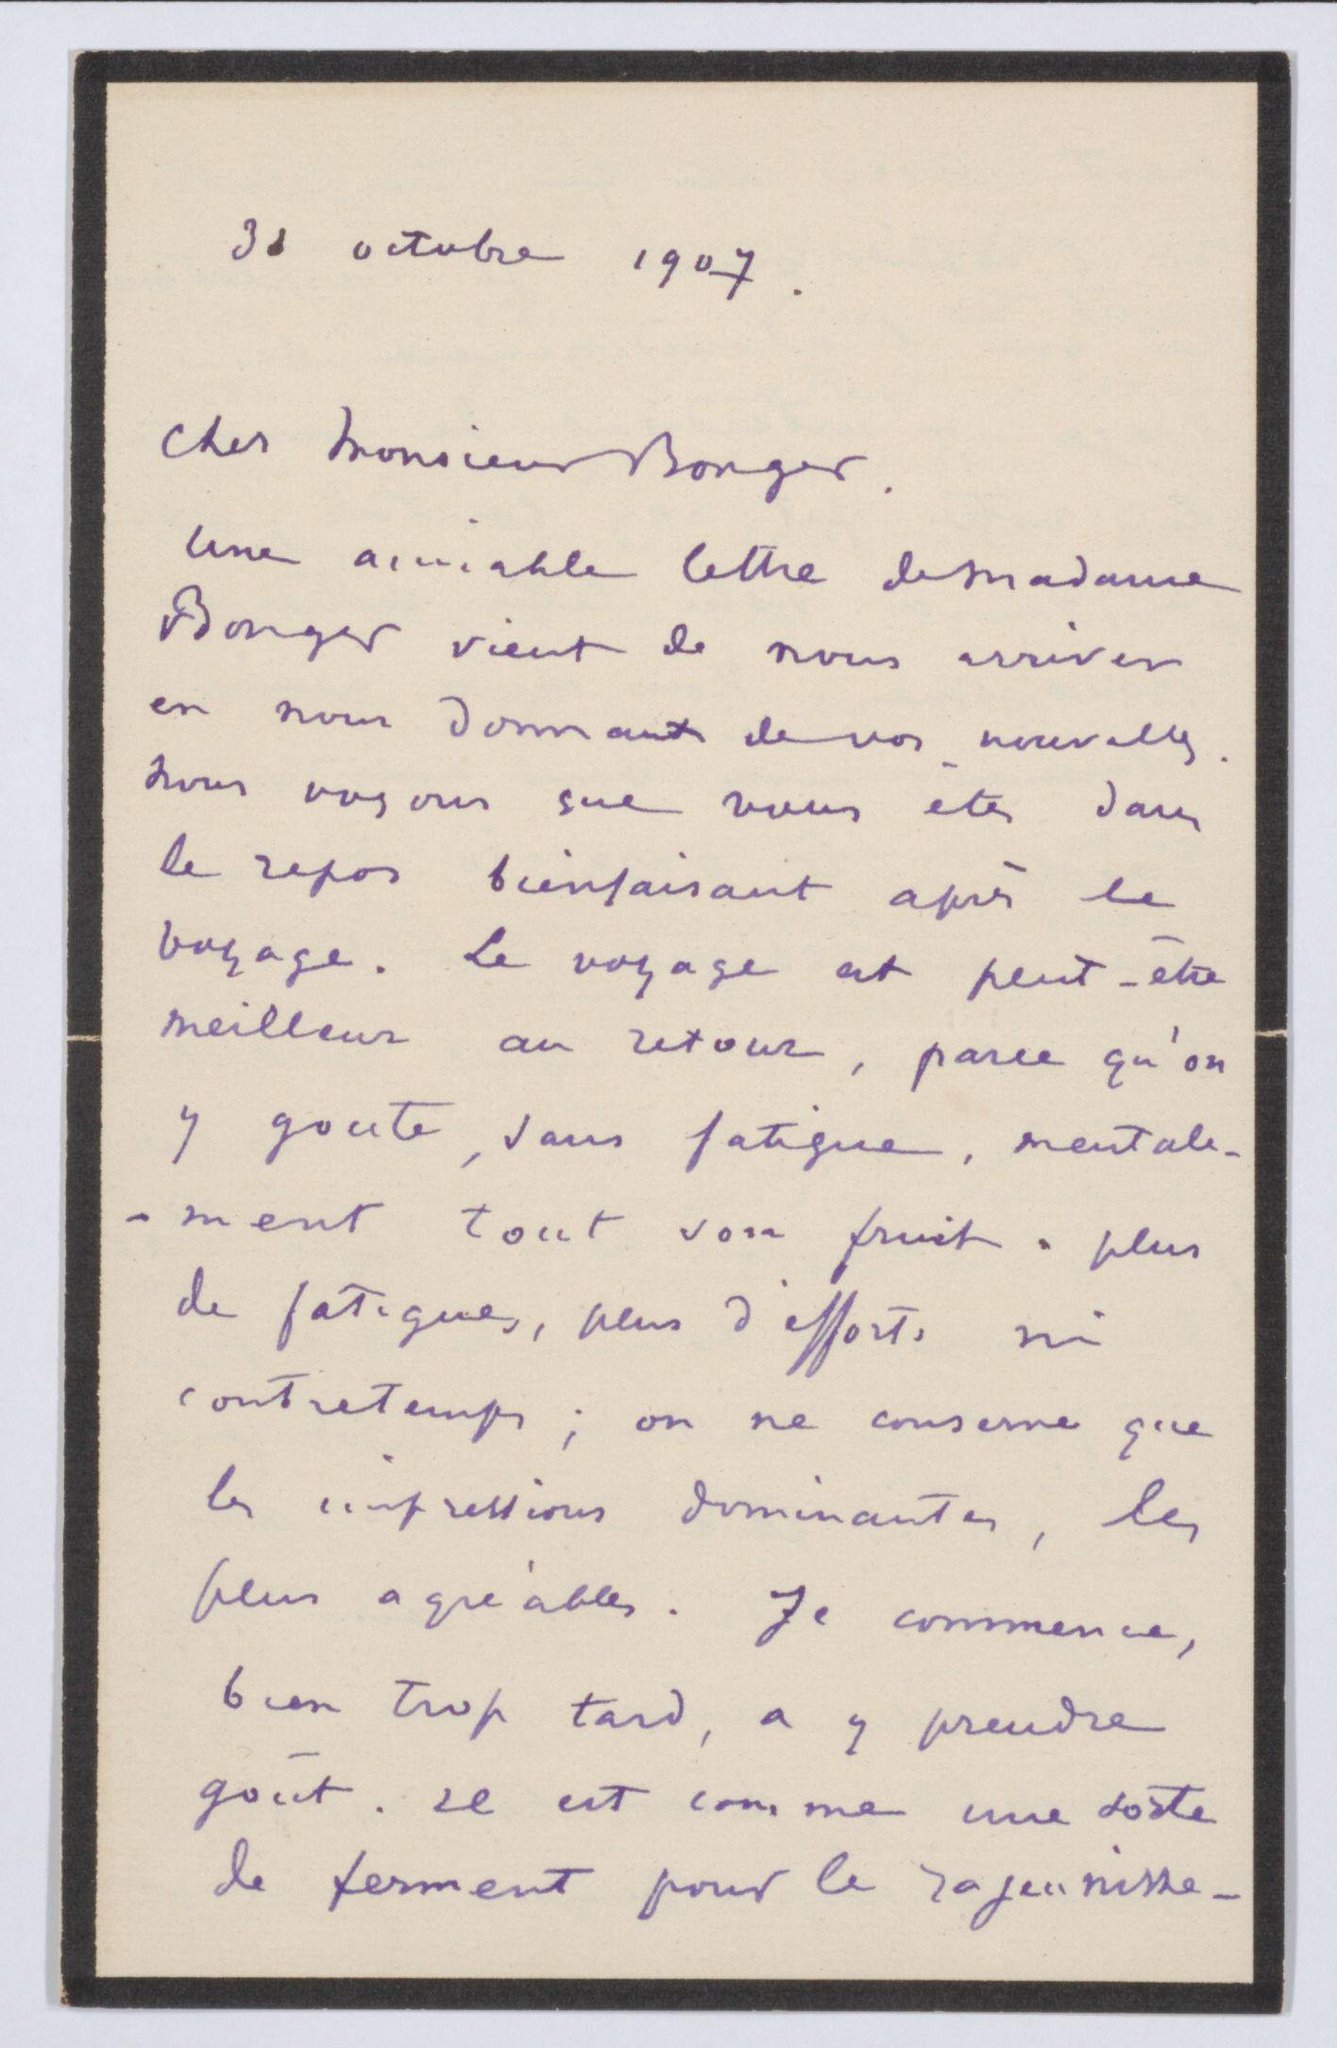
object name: letter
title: Brief aan Andries Bonger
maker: odilon redon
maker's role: draughtsman, painter, print maker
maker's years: 1840-1916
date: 1907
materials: ink, paper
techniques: pen, writing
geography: paris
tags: arï redon, homerus, rome, masaccio, leiden, rembrandt van rijn, amsterdam, andries bonger, leonardo da vinci, travelling; tourism, painting (including book-illumination, miniature-painting), architecture, art collecting, historical persons (portraits and scenes from the life), paris, switzerland